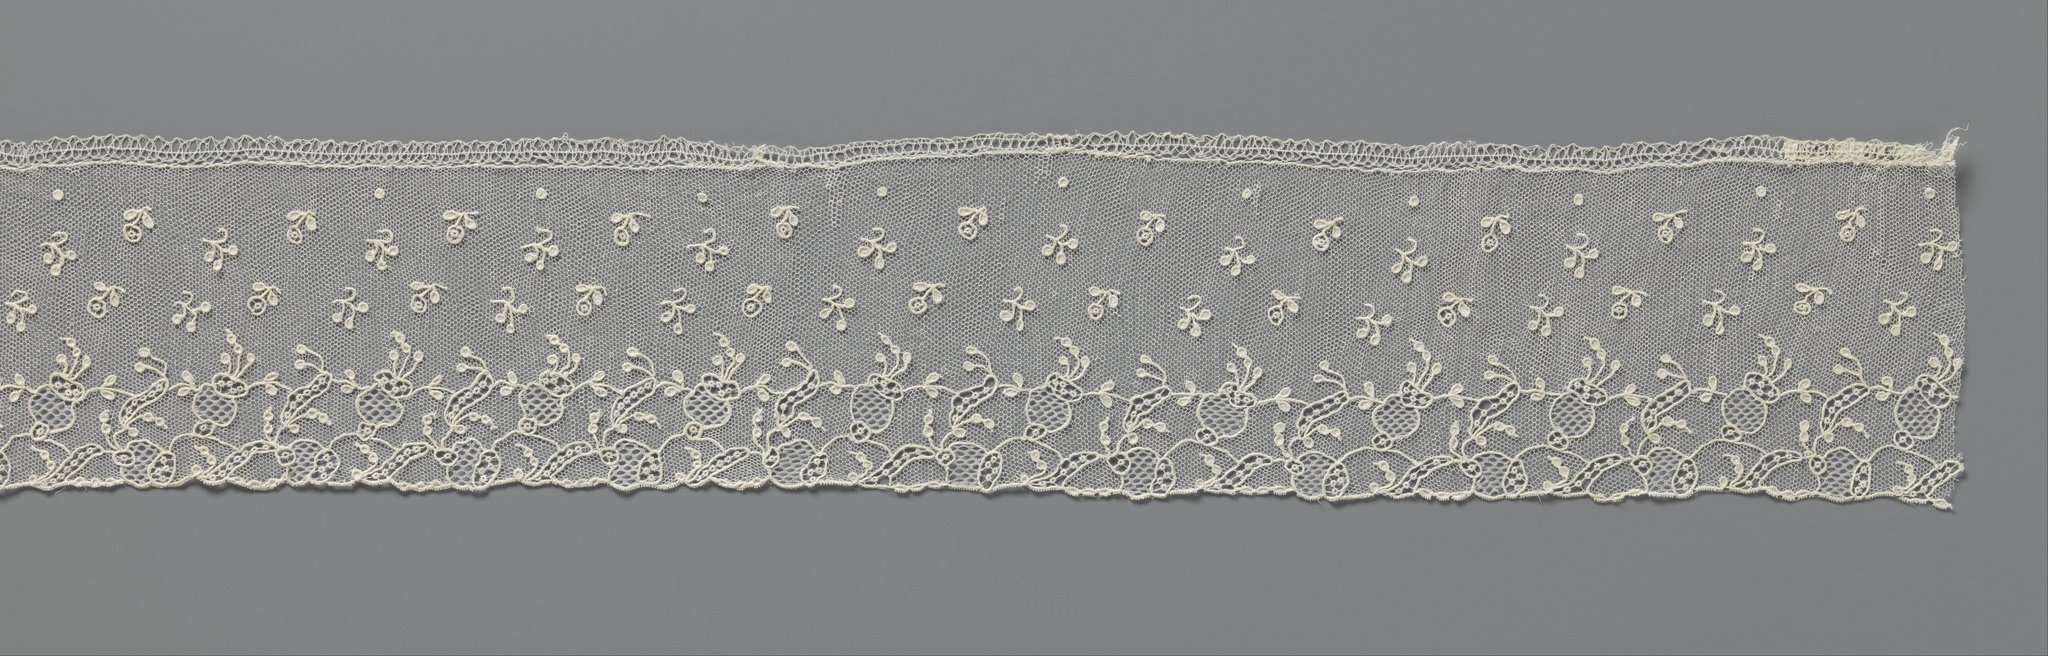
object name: strip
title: Strook naaldkant met papaverbollen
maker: Anonymous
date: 1775-1799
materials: linen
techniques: lace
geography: alençon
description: Strook naturelkleurige naaldkant: Alençon-kant. Strooimotief met onder de bovenste rij moesjes drie rijen takjes met ovale blaadjes, op een fijne zeshoekige maasgrond. Aan de onderzijde van de strook een repetitief motief van papaverbollen, smalle bladeren en fantasievormen gevuld met siergronden. De onderzijde is afgewerkt met een licht golvende rand met ragfijne picots. De bovenzijde is afgezet met een rand kloskant.